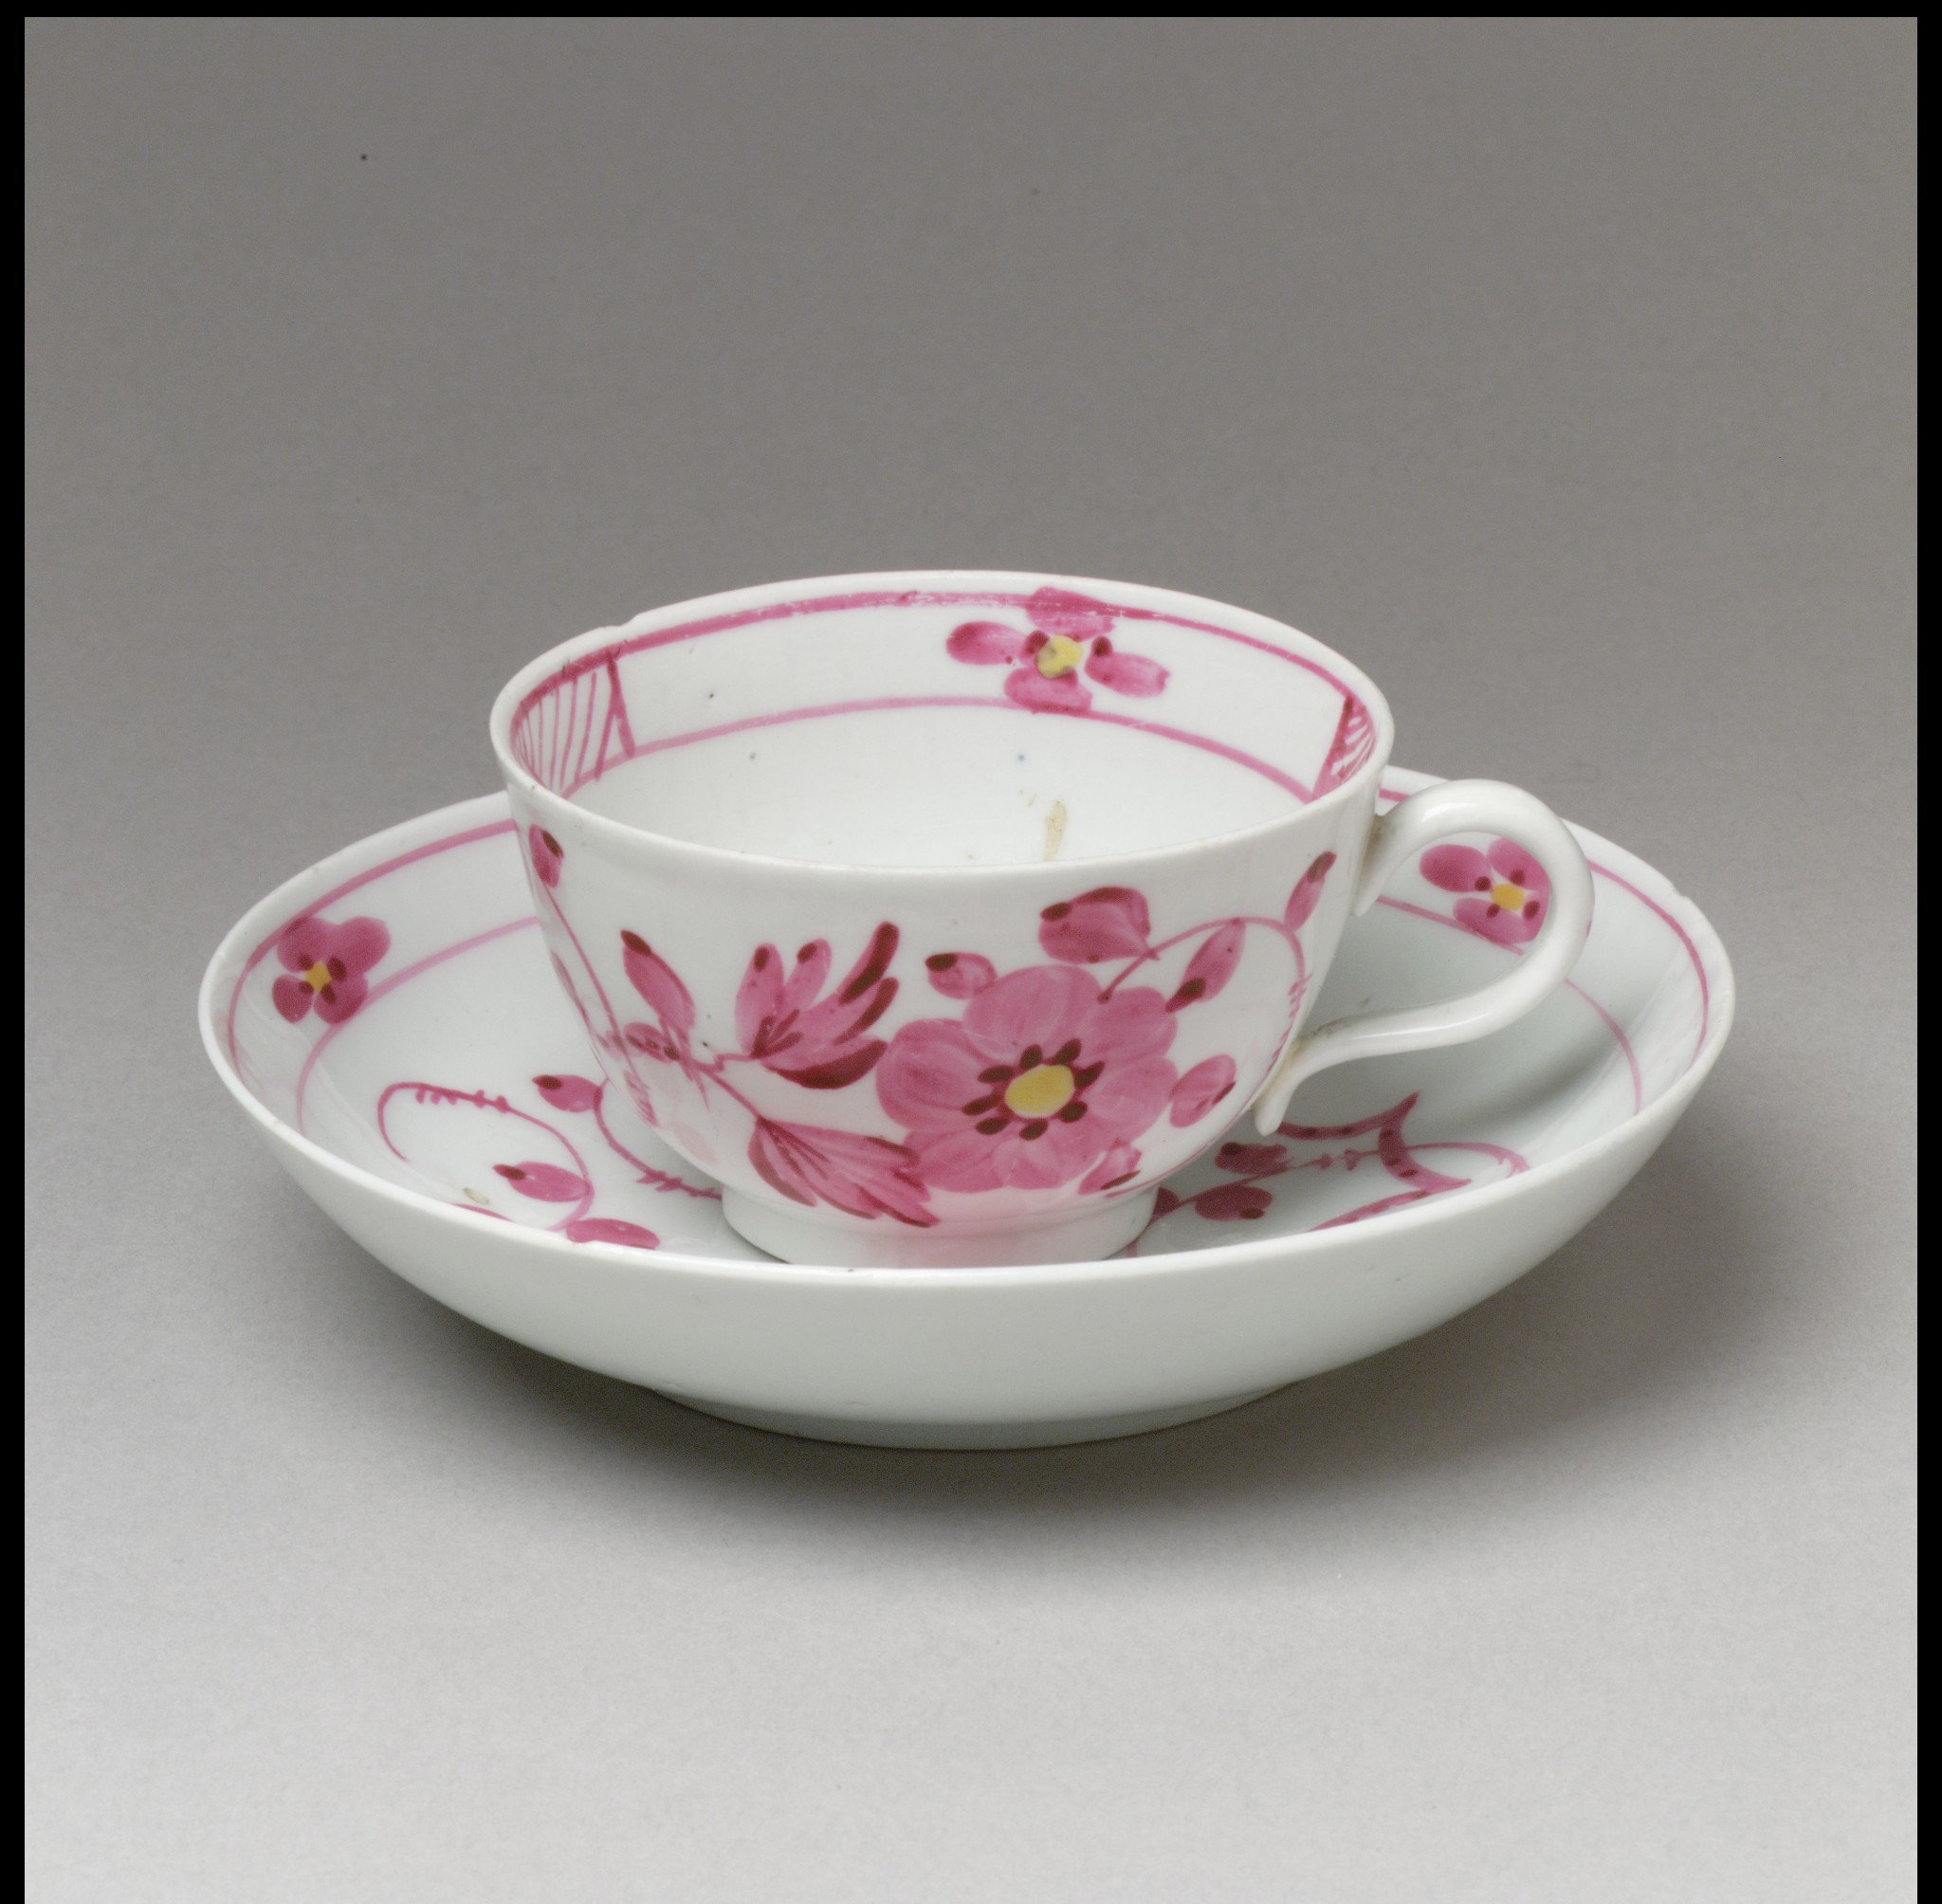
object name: cup and saucer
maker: ilmenau porcelain manufactory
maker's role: manufactory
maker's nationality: german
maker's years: 1777-1871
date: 1775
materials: hard paste porcelain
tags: flowers